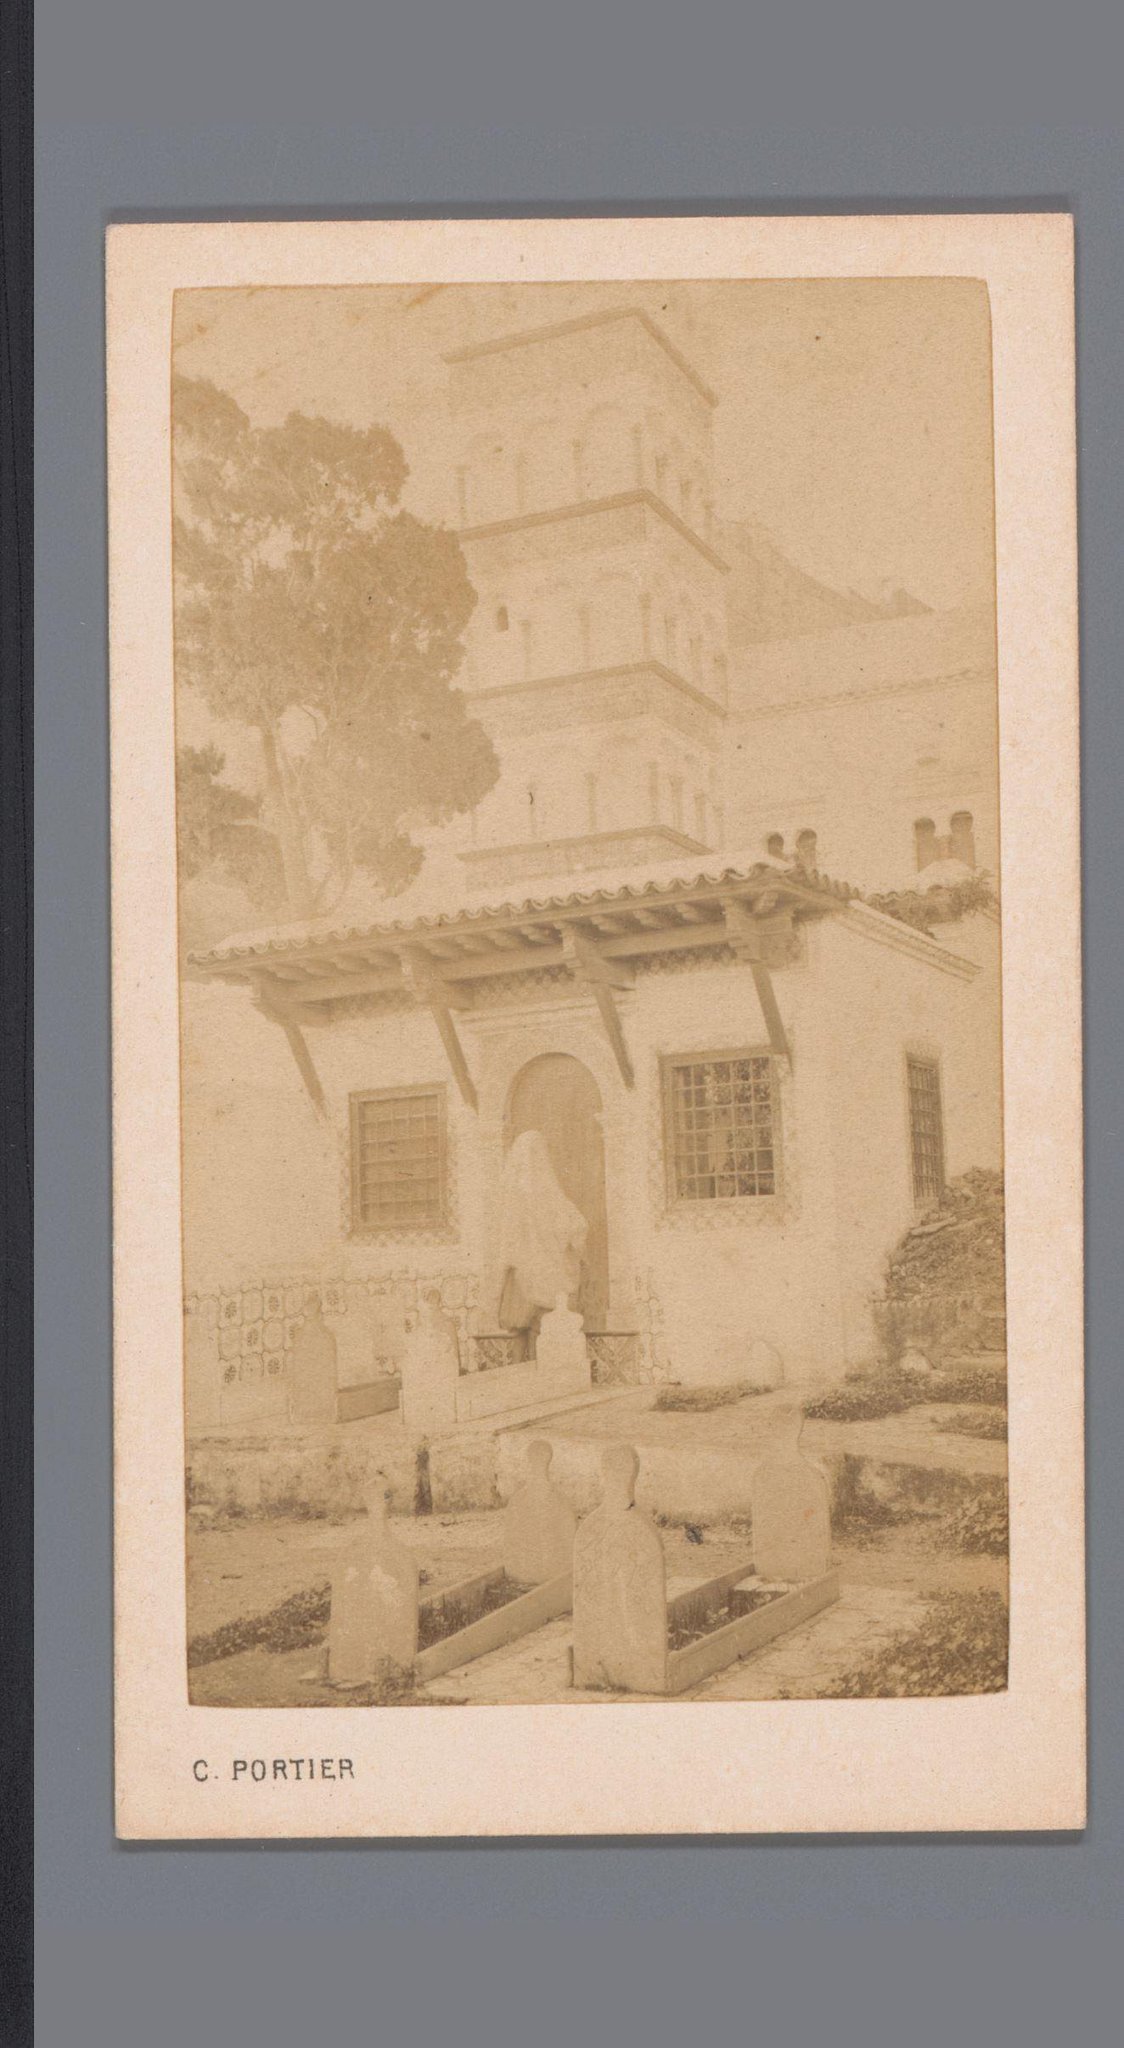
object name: carte de visite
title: Gebouw bij een begraafplaats, Algiers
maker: claude-joseph portier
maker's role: fotograaf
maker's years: 1841-1910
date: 1863-1882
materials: cardboard, paper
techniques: albumen print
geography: algiers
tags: churchyard, cemetery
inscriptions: inscription: ‘C. Portier’, inscription: ‘C. Portier/ Photographe Paysagiste/ Alger/ Vues et types de toute l'Algérie/ Magasin de vente/ Rue bab-Azoun,/ (au coin de la Rue de la Flèche)’